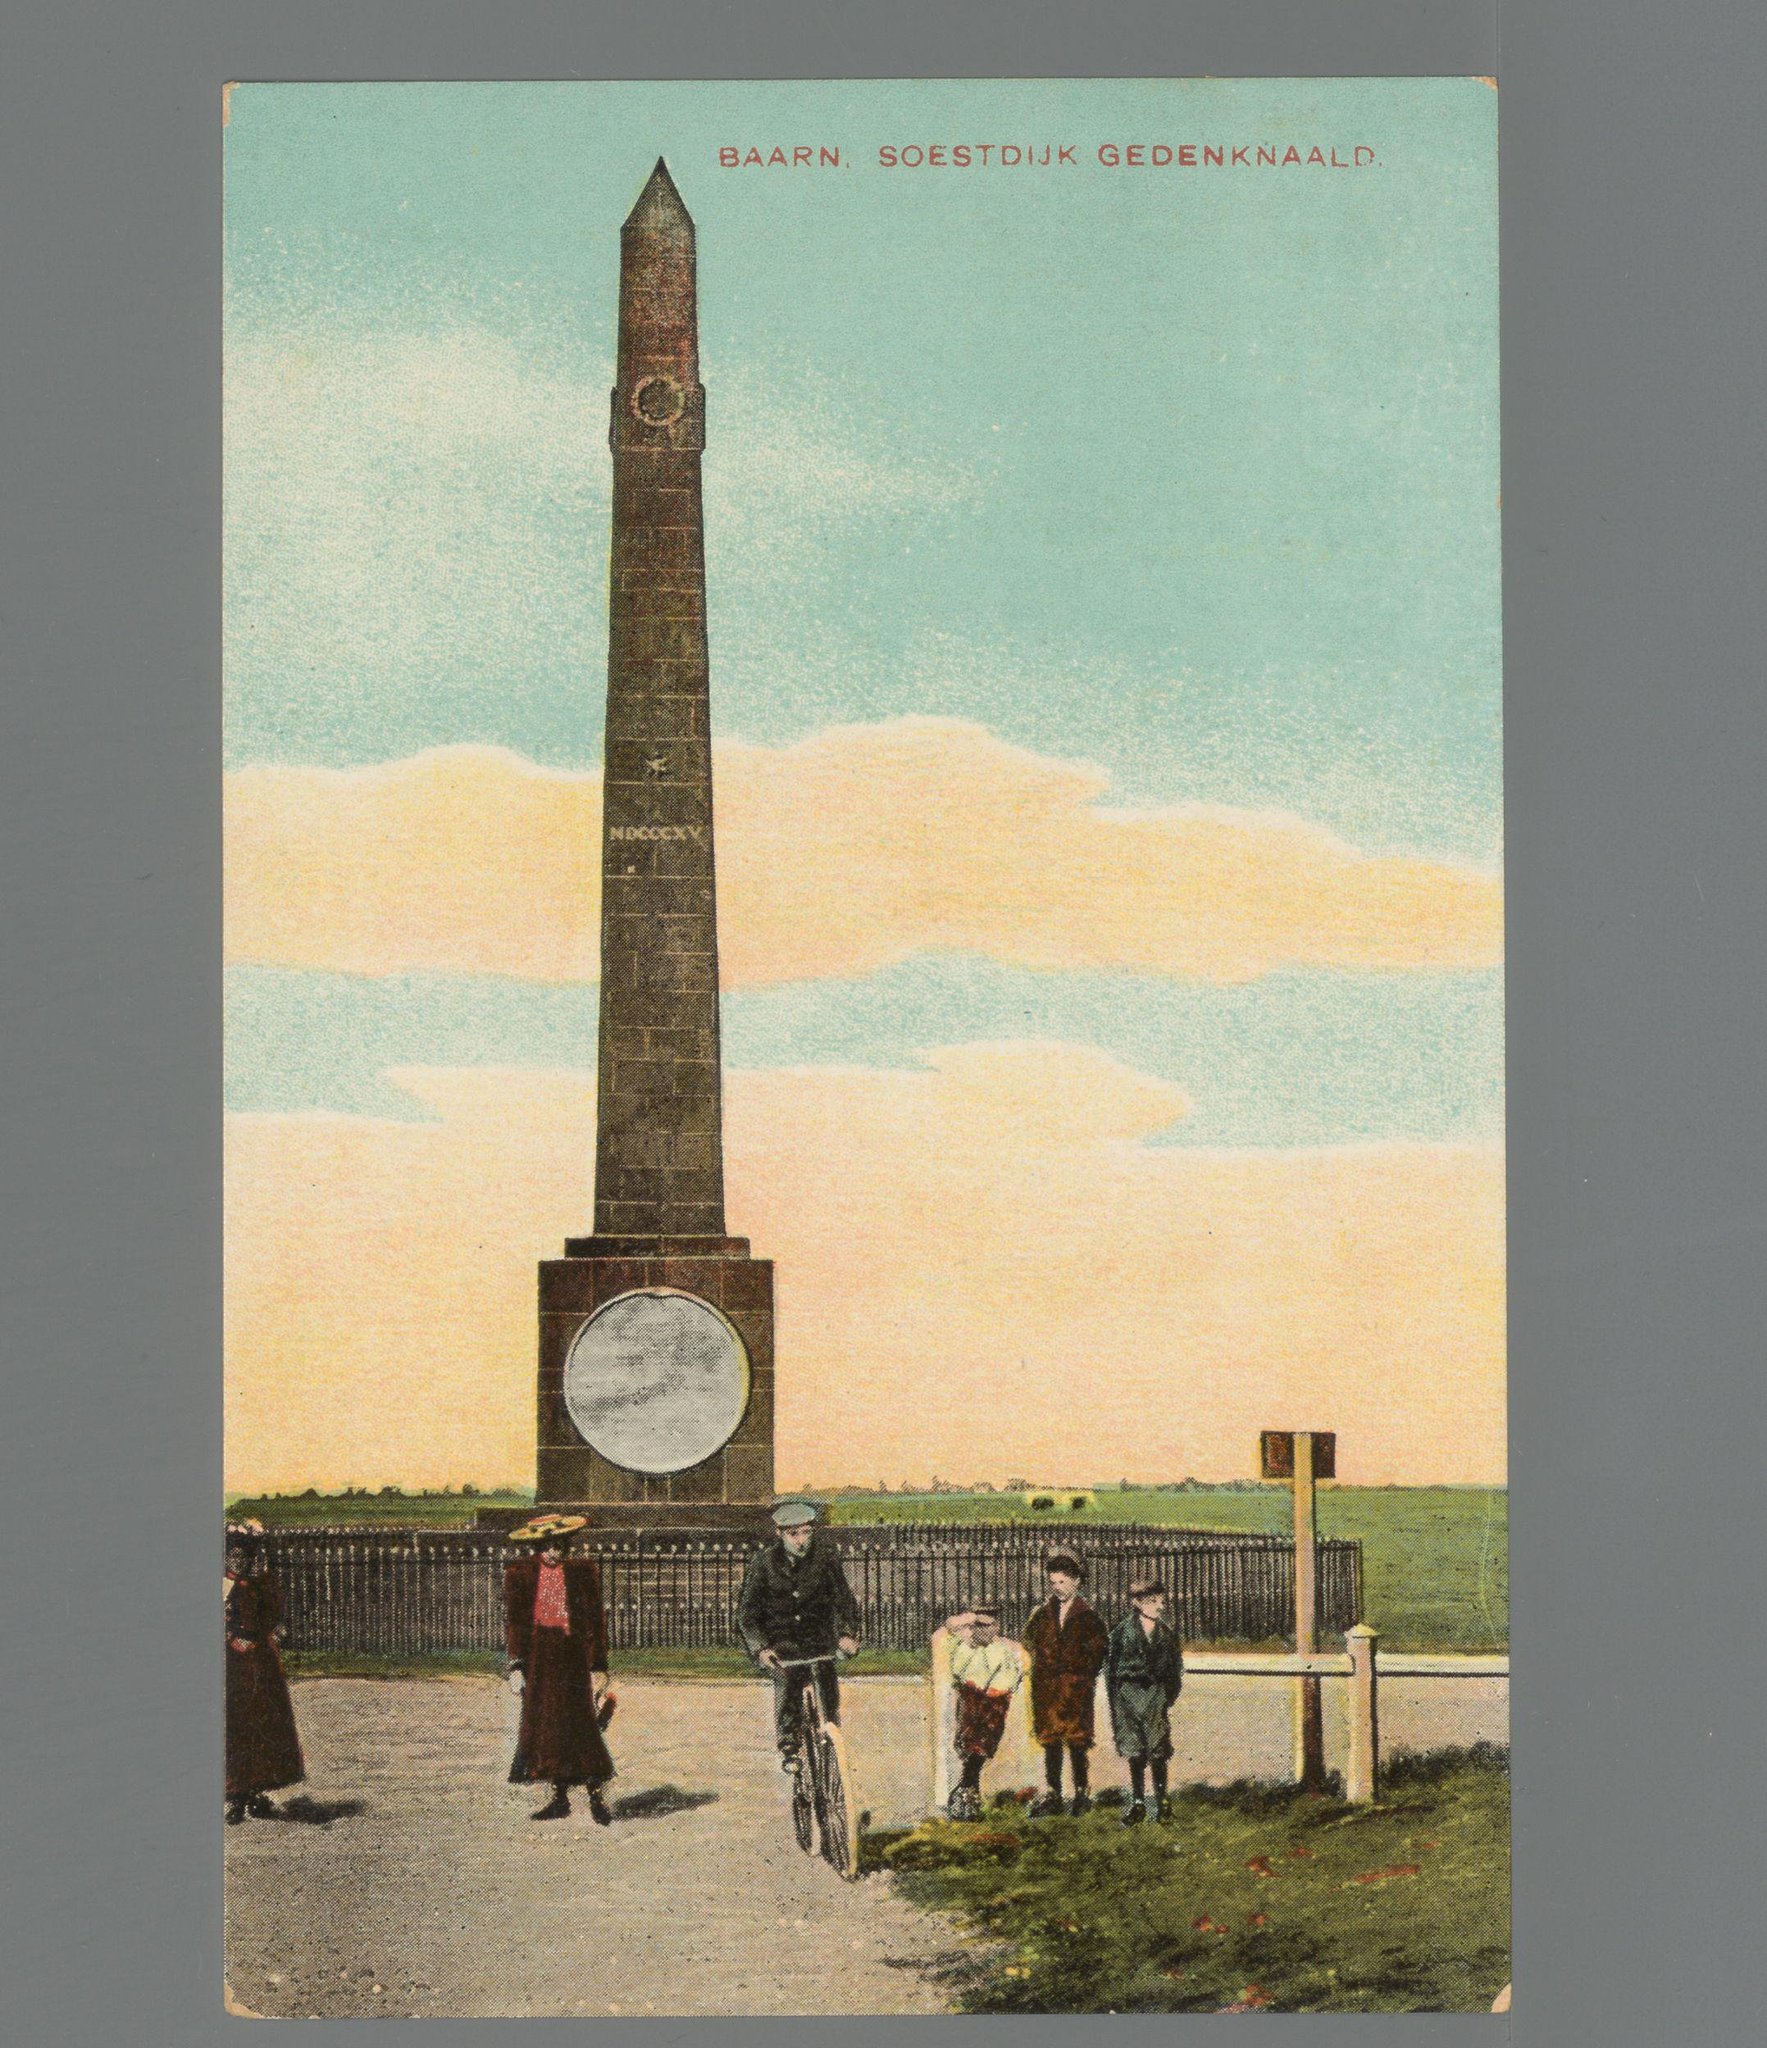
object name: ansichtkaart, prentbriefkaart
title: Kunstchromo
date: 1905-1909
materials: cardboard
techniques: lithograph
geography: amsterdam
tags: obelisk, needle